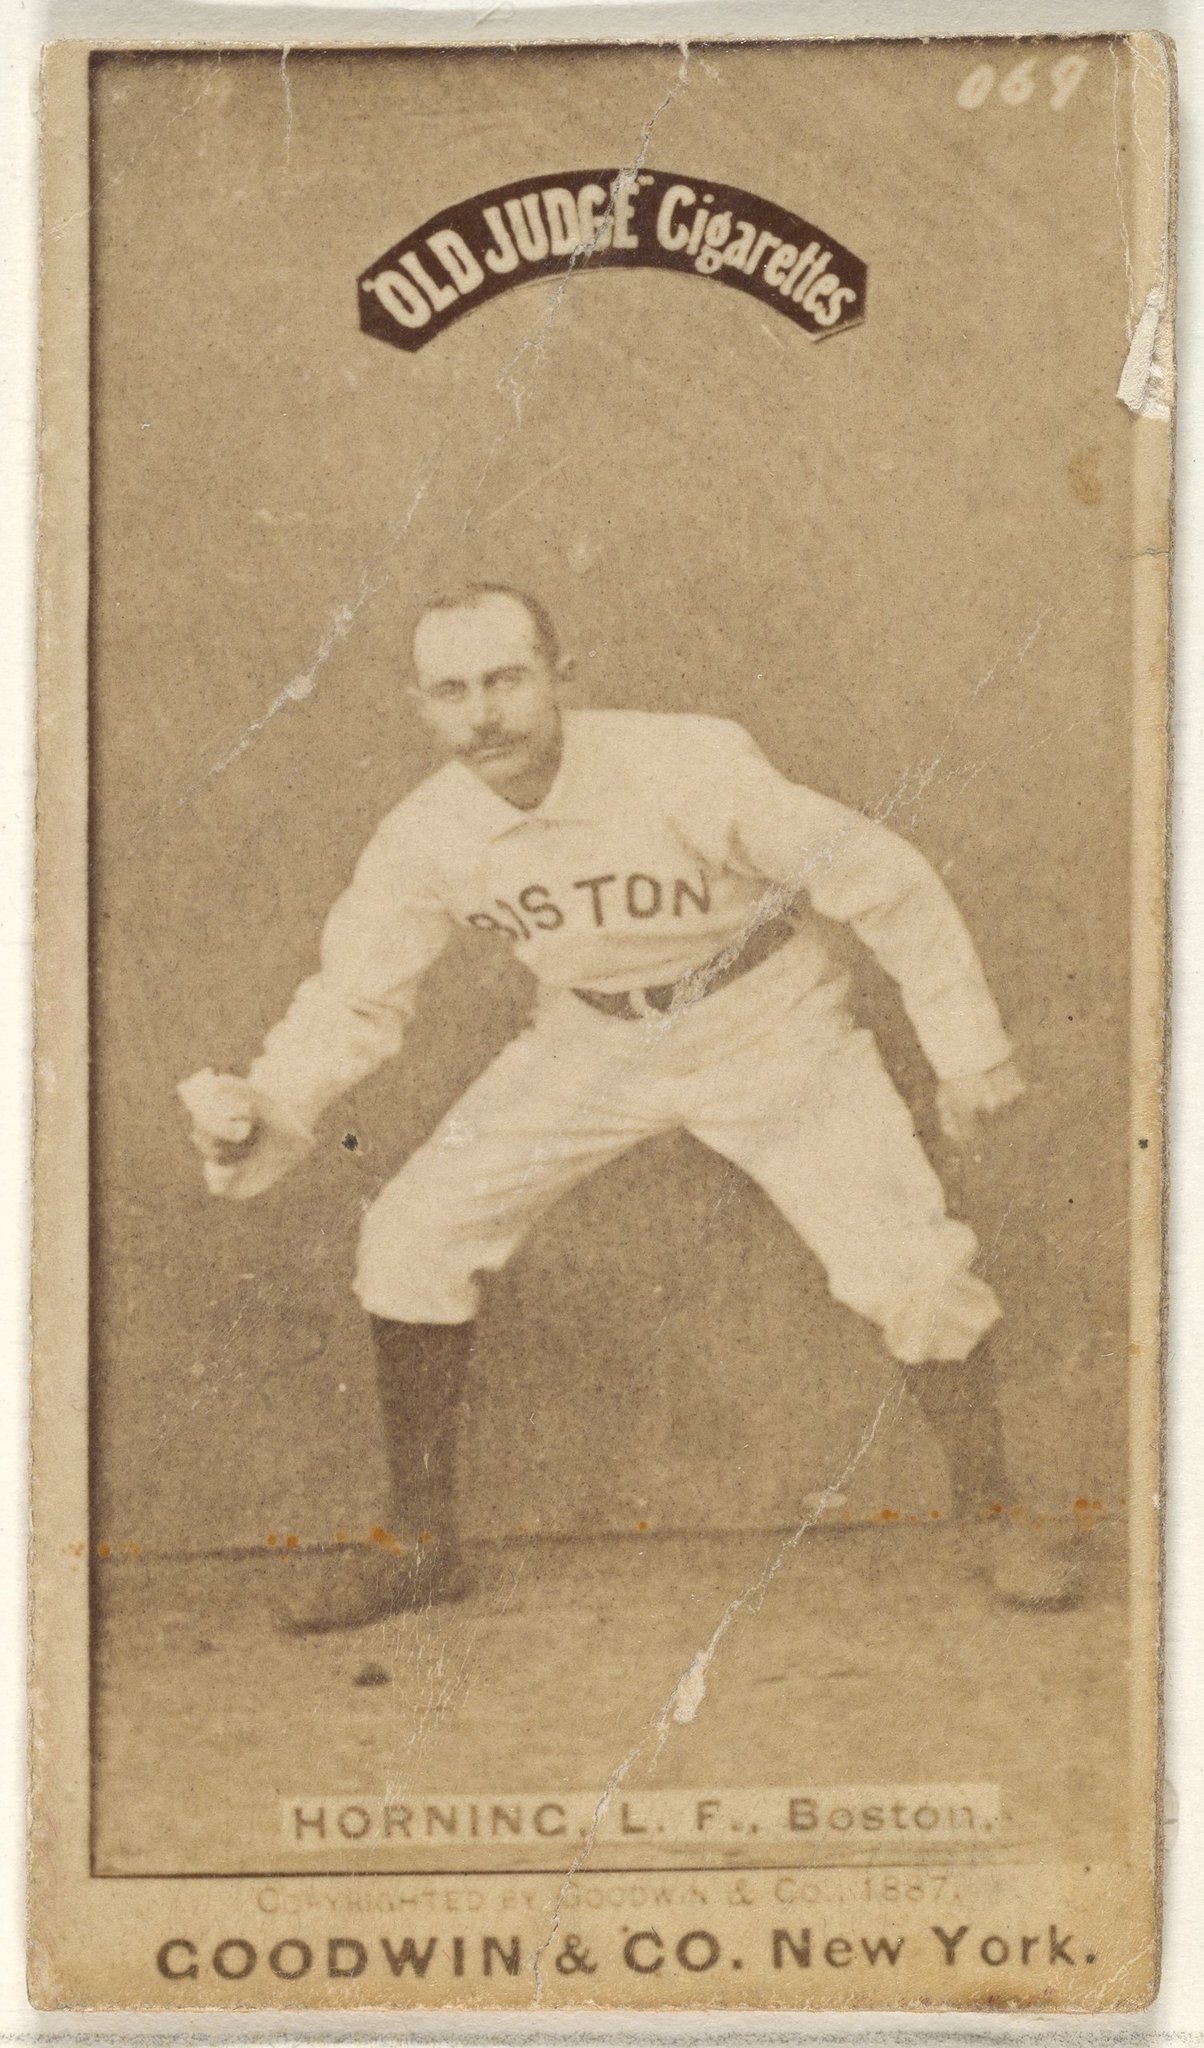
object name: baseball card, photograph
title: Horning, Left Field, Boston, from the Old Judge series (N172) for Old Judge Cigarettes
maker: goodwin & company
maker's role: publisher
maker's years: 1850-1950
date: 1887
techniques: albumen silver print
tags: men,portraits,baseball,athletes